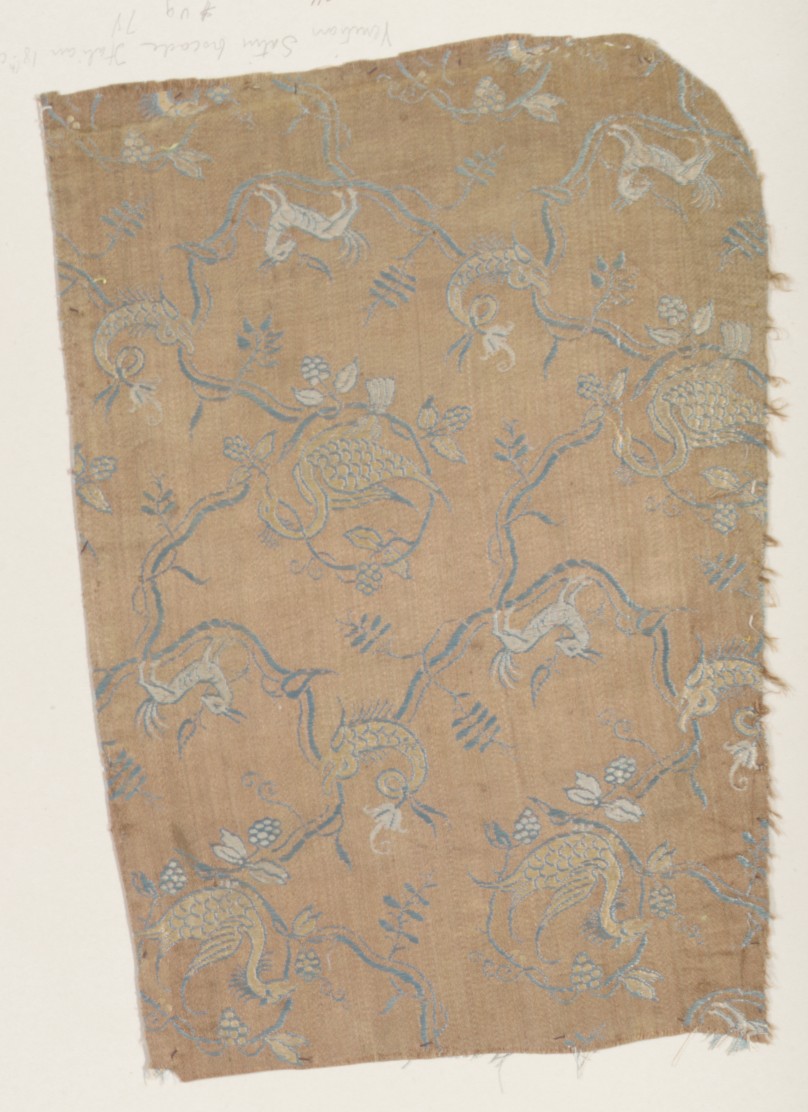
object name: fragment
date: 1701-1800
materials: silk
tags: animals,birds,leaves